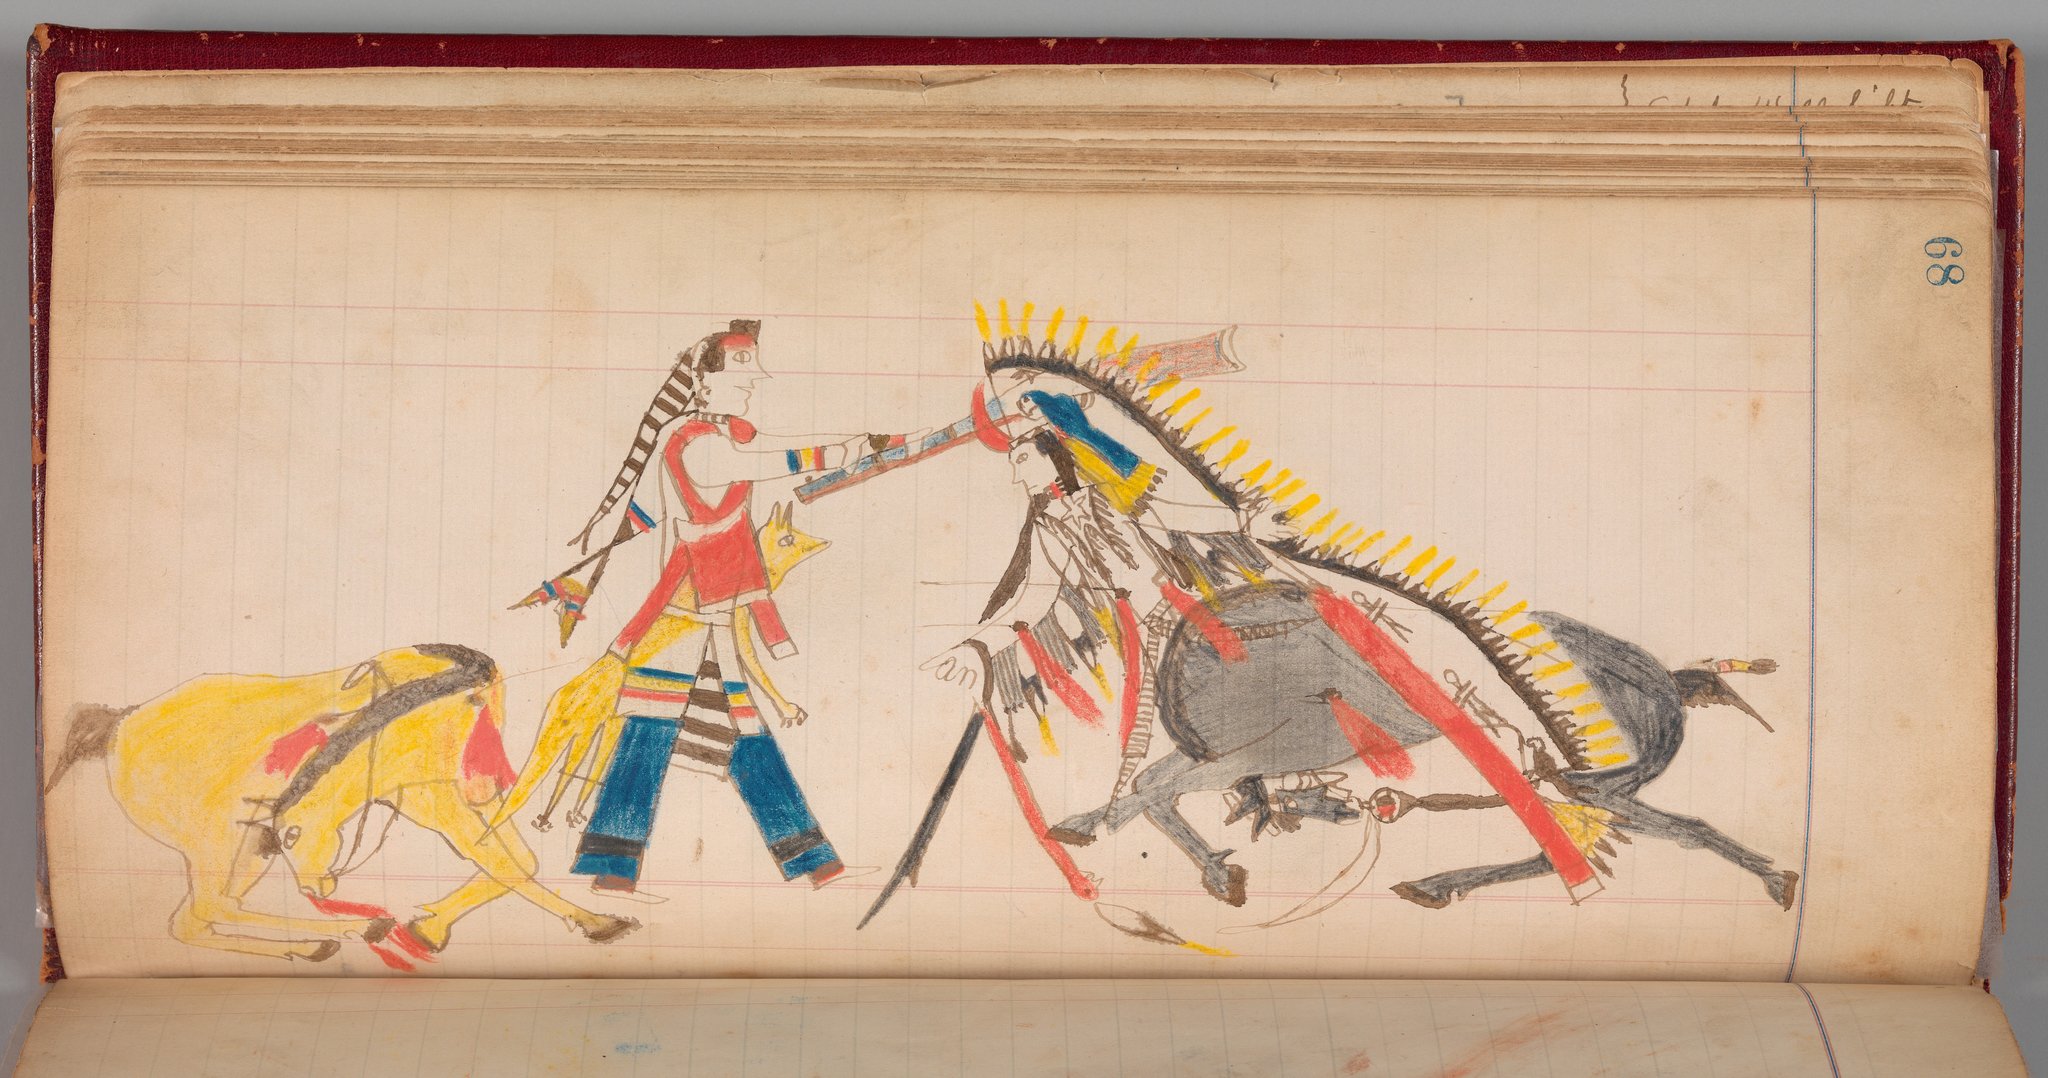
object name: drawing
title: Maffet Ledger: Drawing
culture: cheyenne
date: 1874-1881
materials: crayon, graphite, paper, watercolor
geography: united states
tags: men,horses